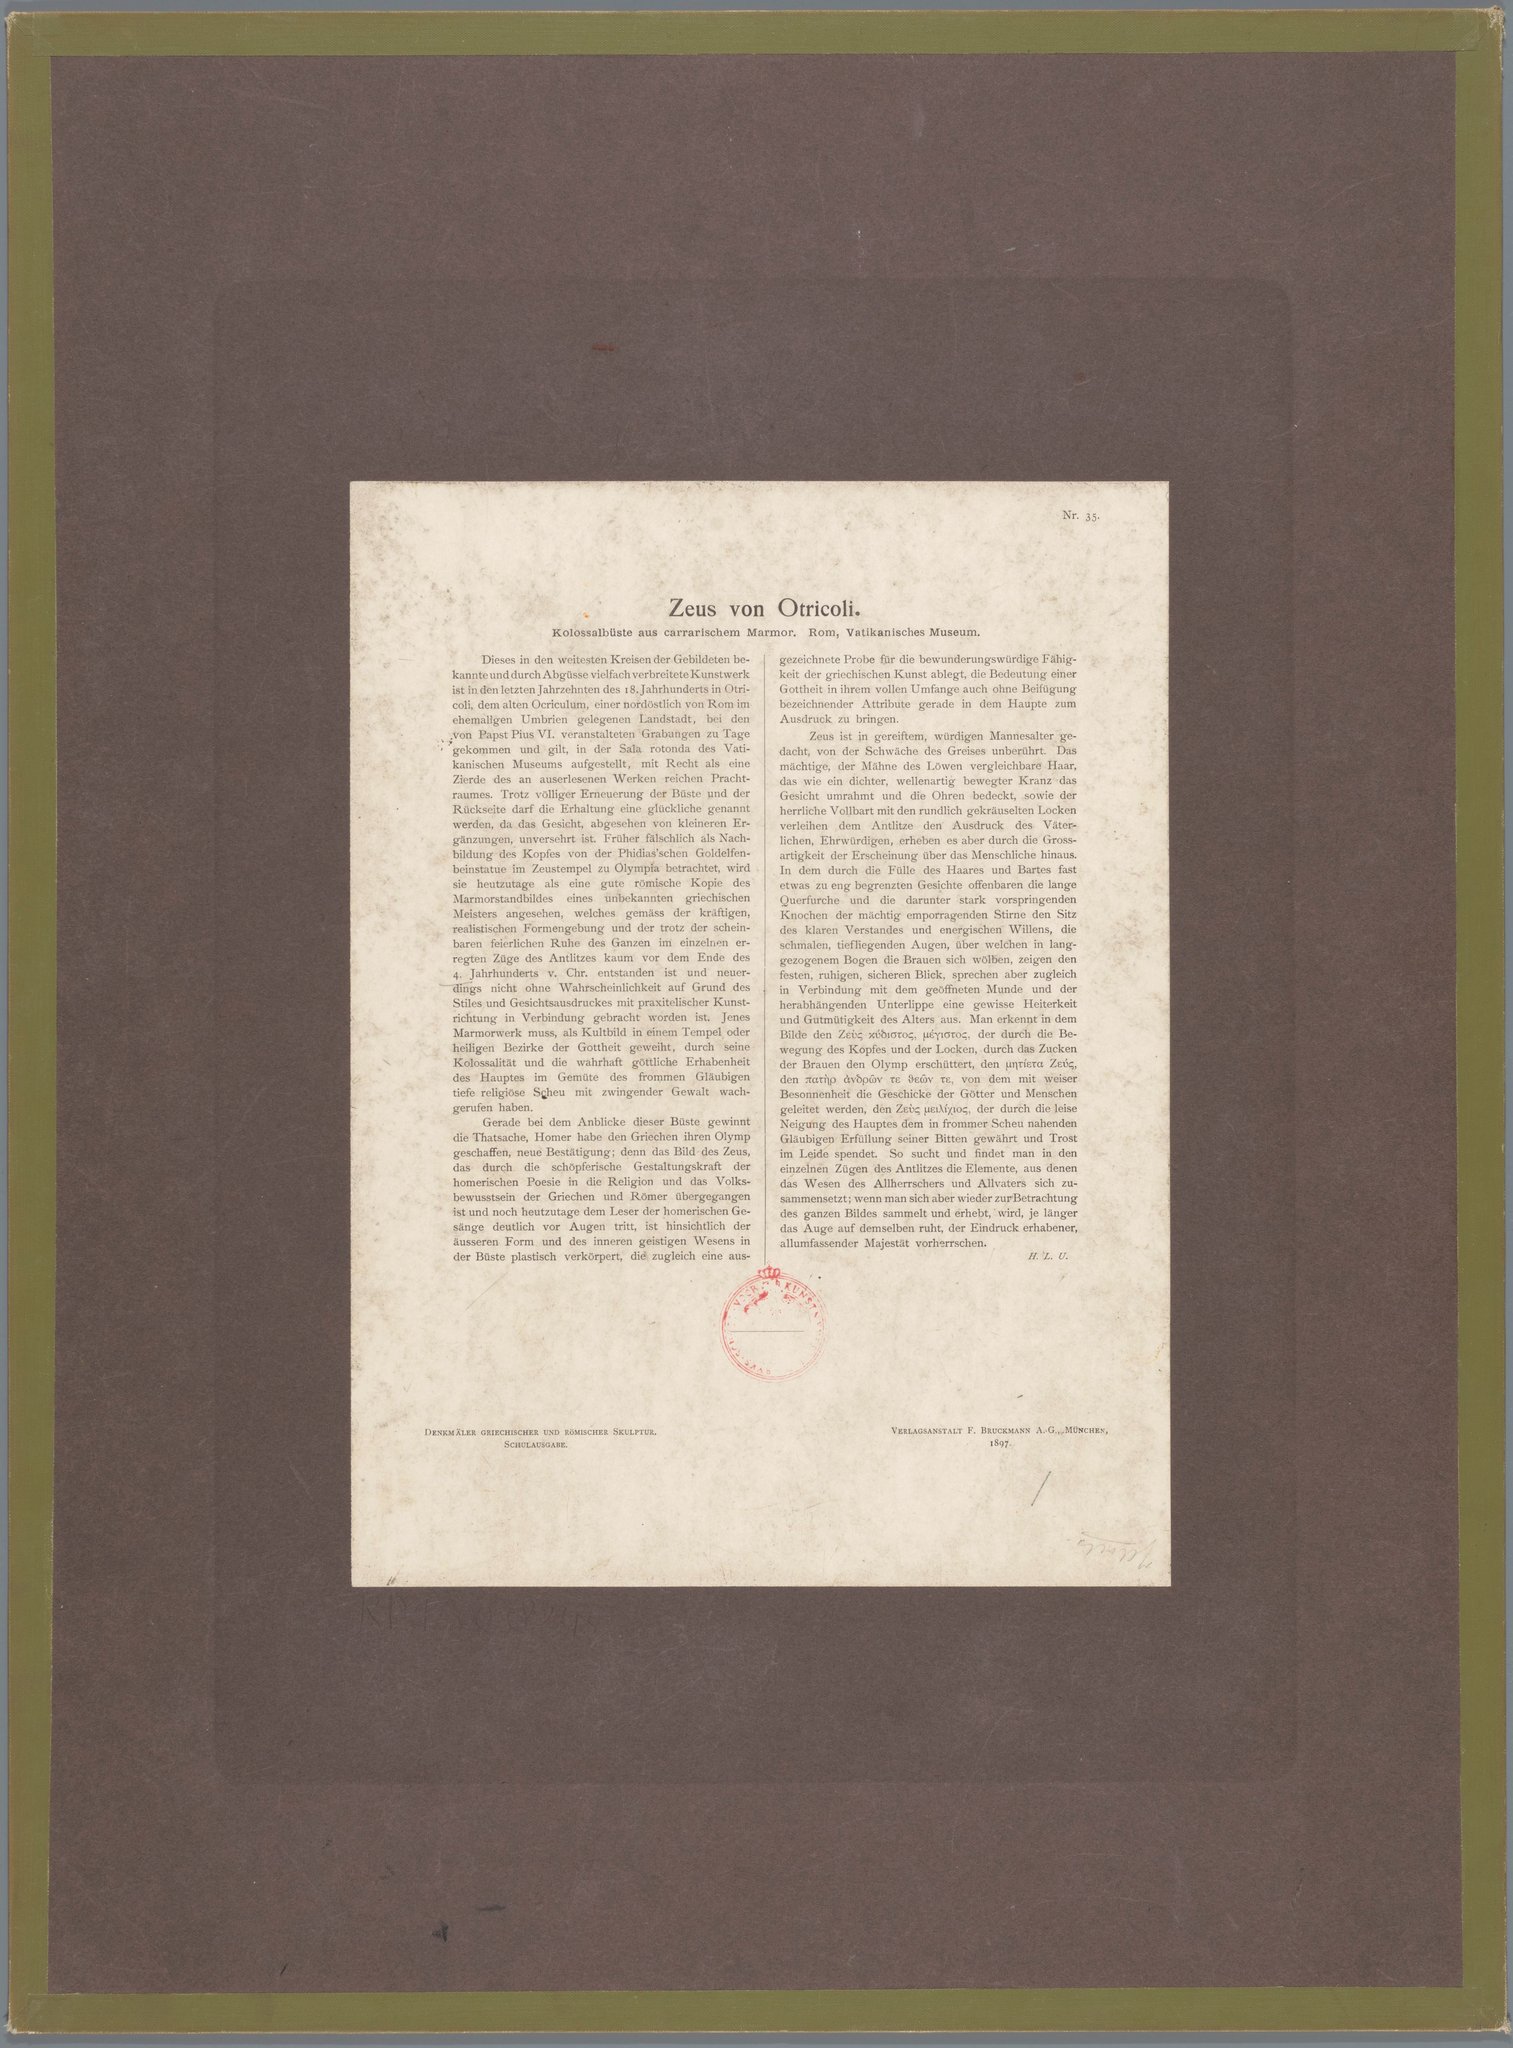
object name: photograph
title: Zeus von Otricoli.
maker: Anonymous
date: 1897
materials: cardboard, paper, ink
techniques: photograph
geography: vatican museums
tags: (story of) jupiter (zeus), sculpture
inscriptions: number: ‘Nr. 35.’, inscription:, collector's mark: Lugt 3937